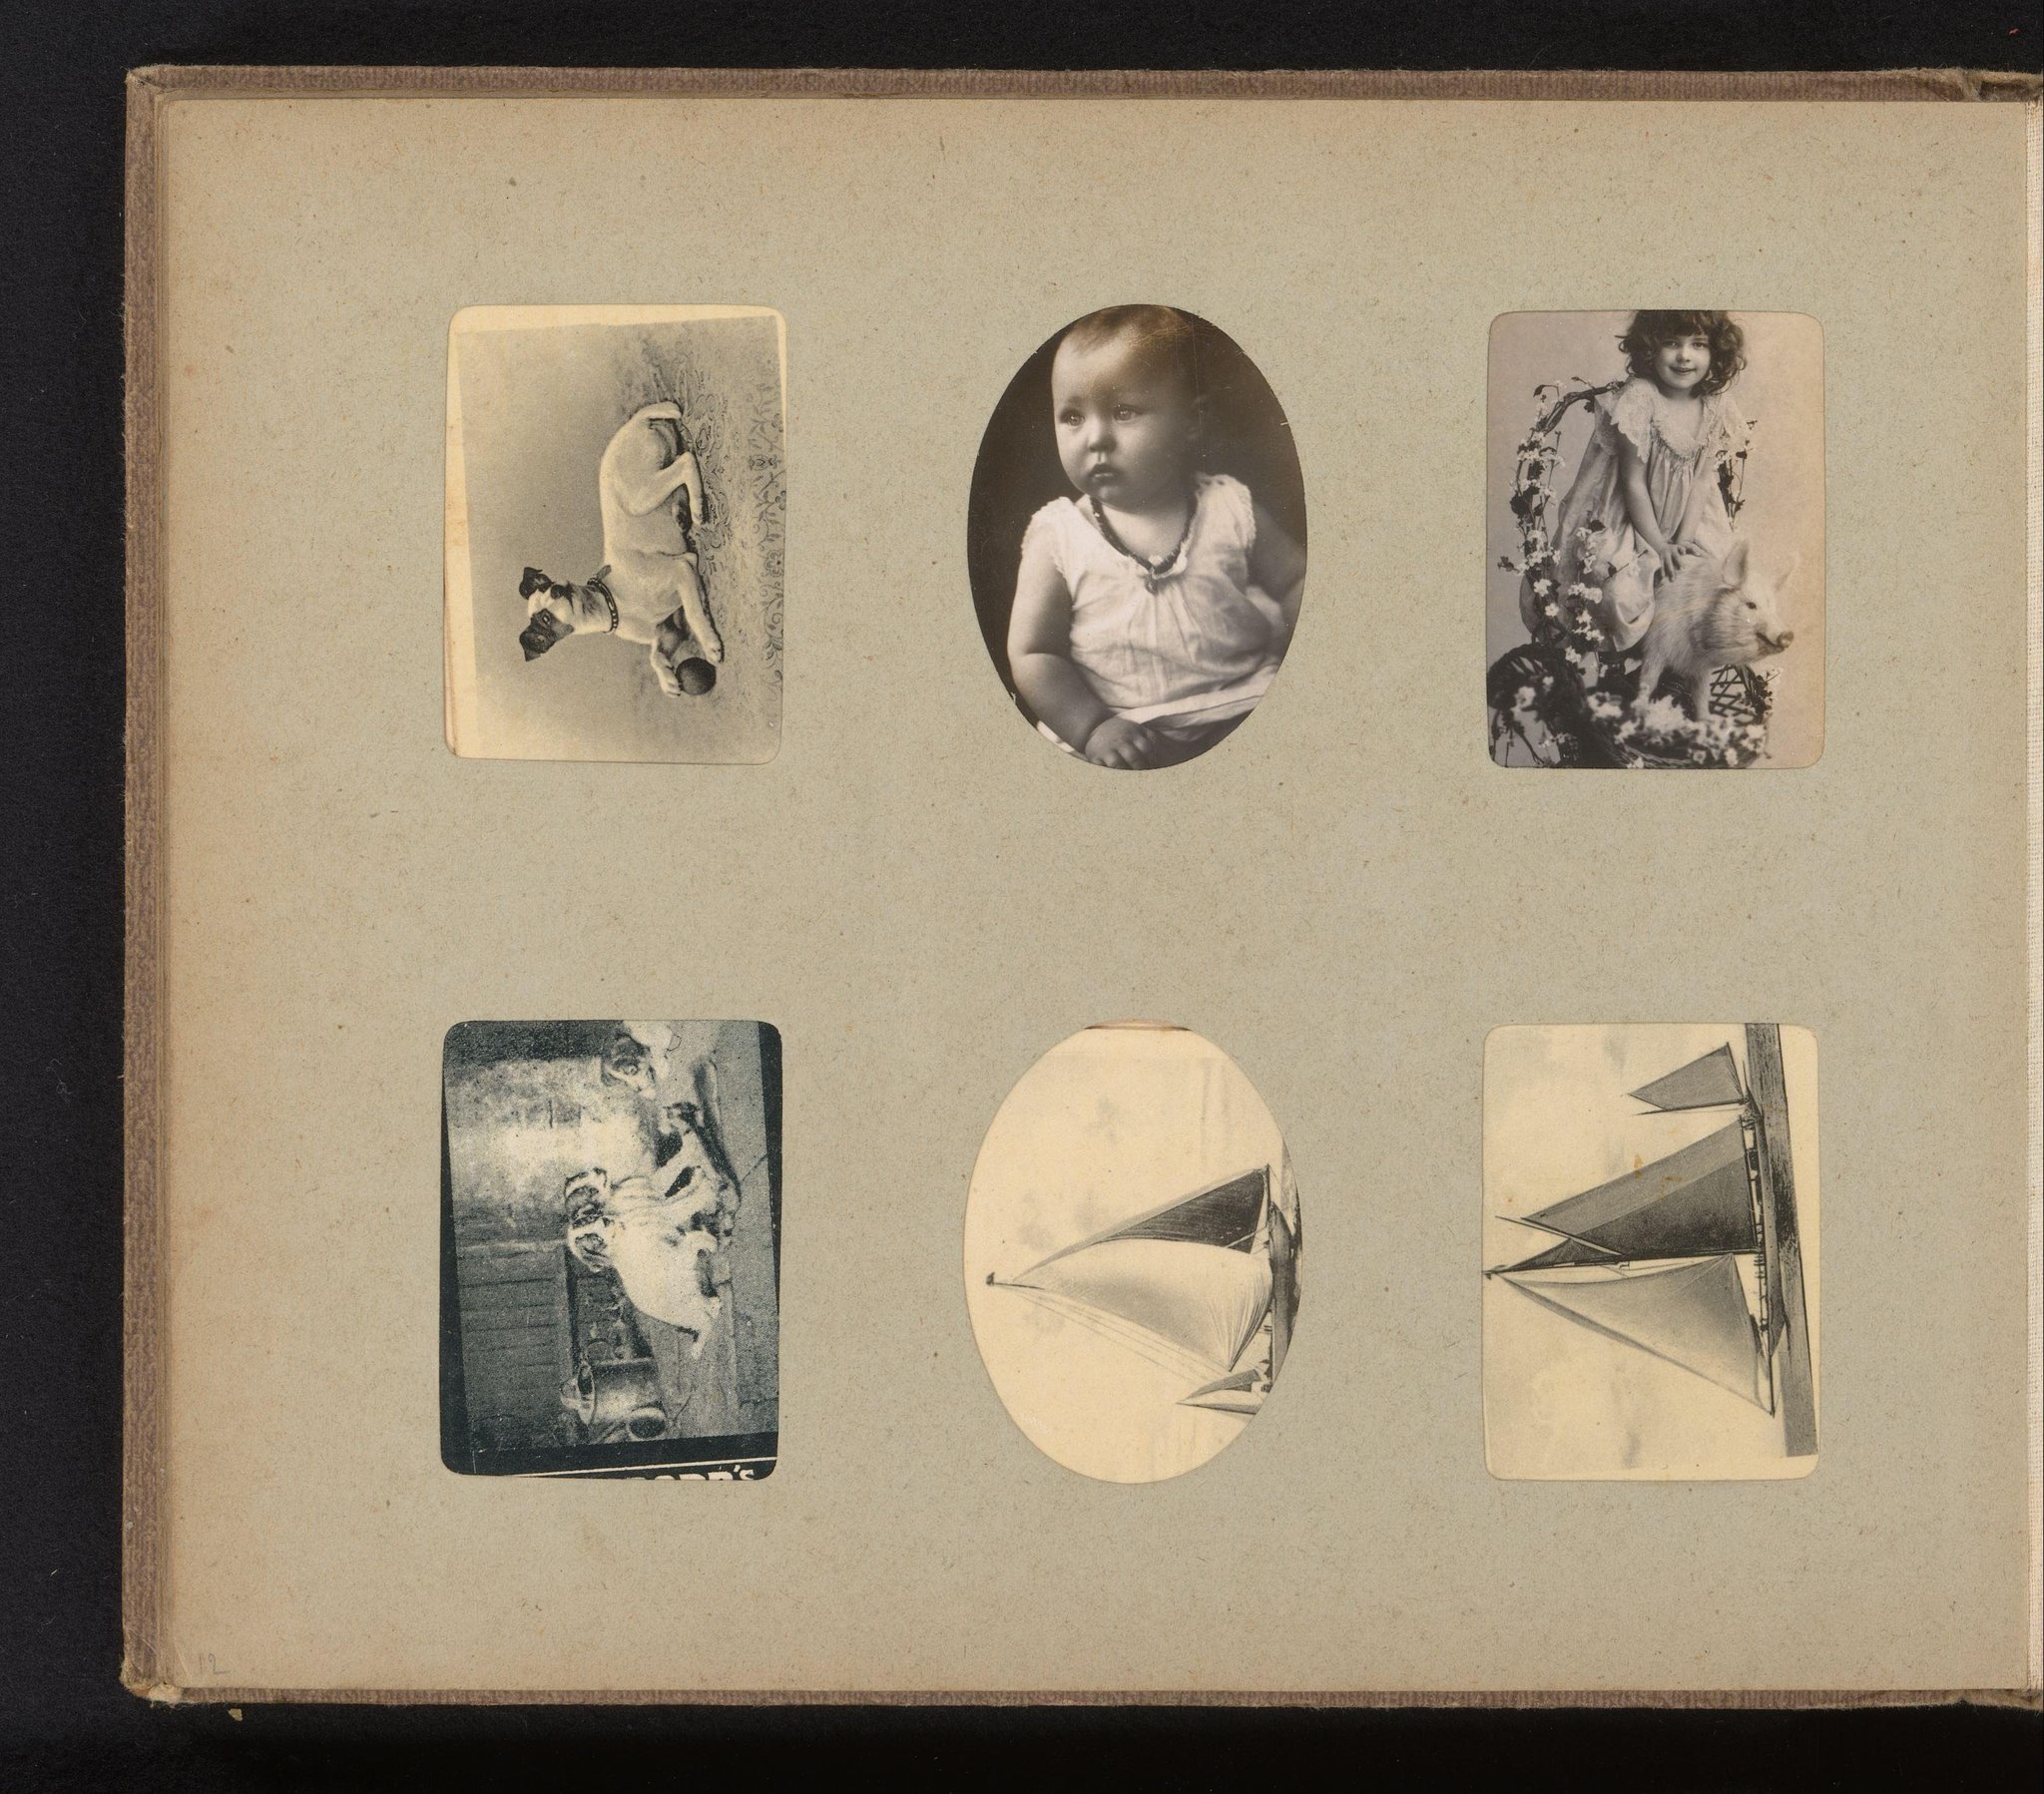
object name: album leaf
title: Diverse onderwerpen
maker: Anonymous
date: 1890-1900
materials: cardboard, paper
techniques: photograph, gelatin silver print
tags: adolescent, young woman, maiden, child (at home)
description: Twee portretten van kinderen, een hond met bal, twee reproducties van werken met een zeilboot en één reproductie van een werk met drie honden. Deze pagina is deel van een album.